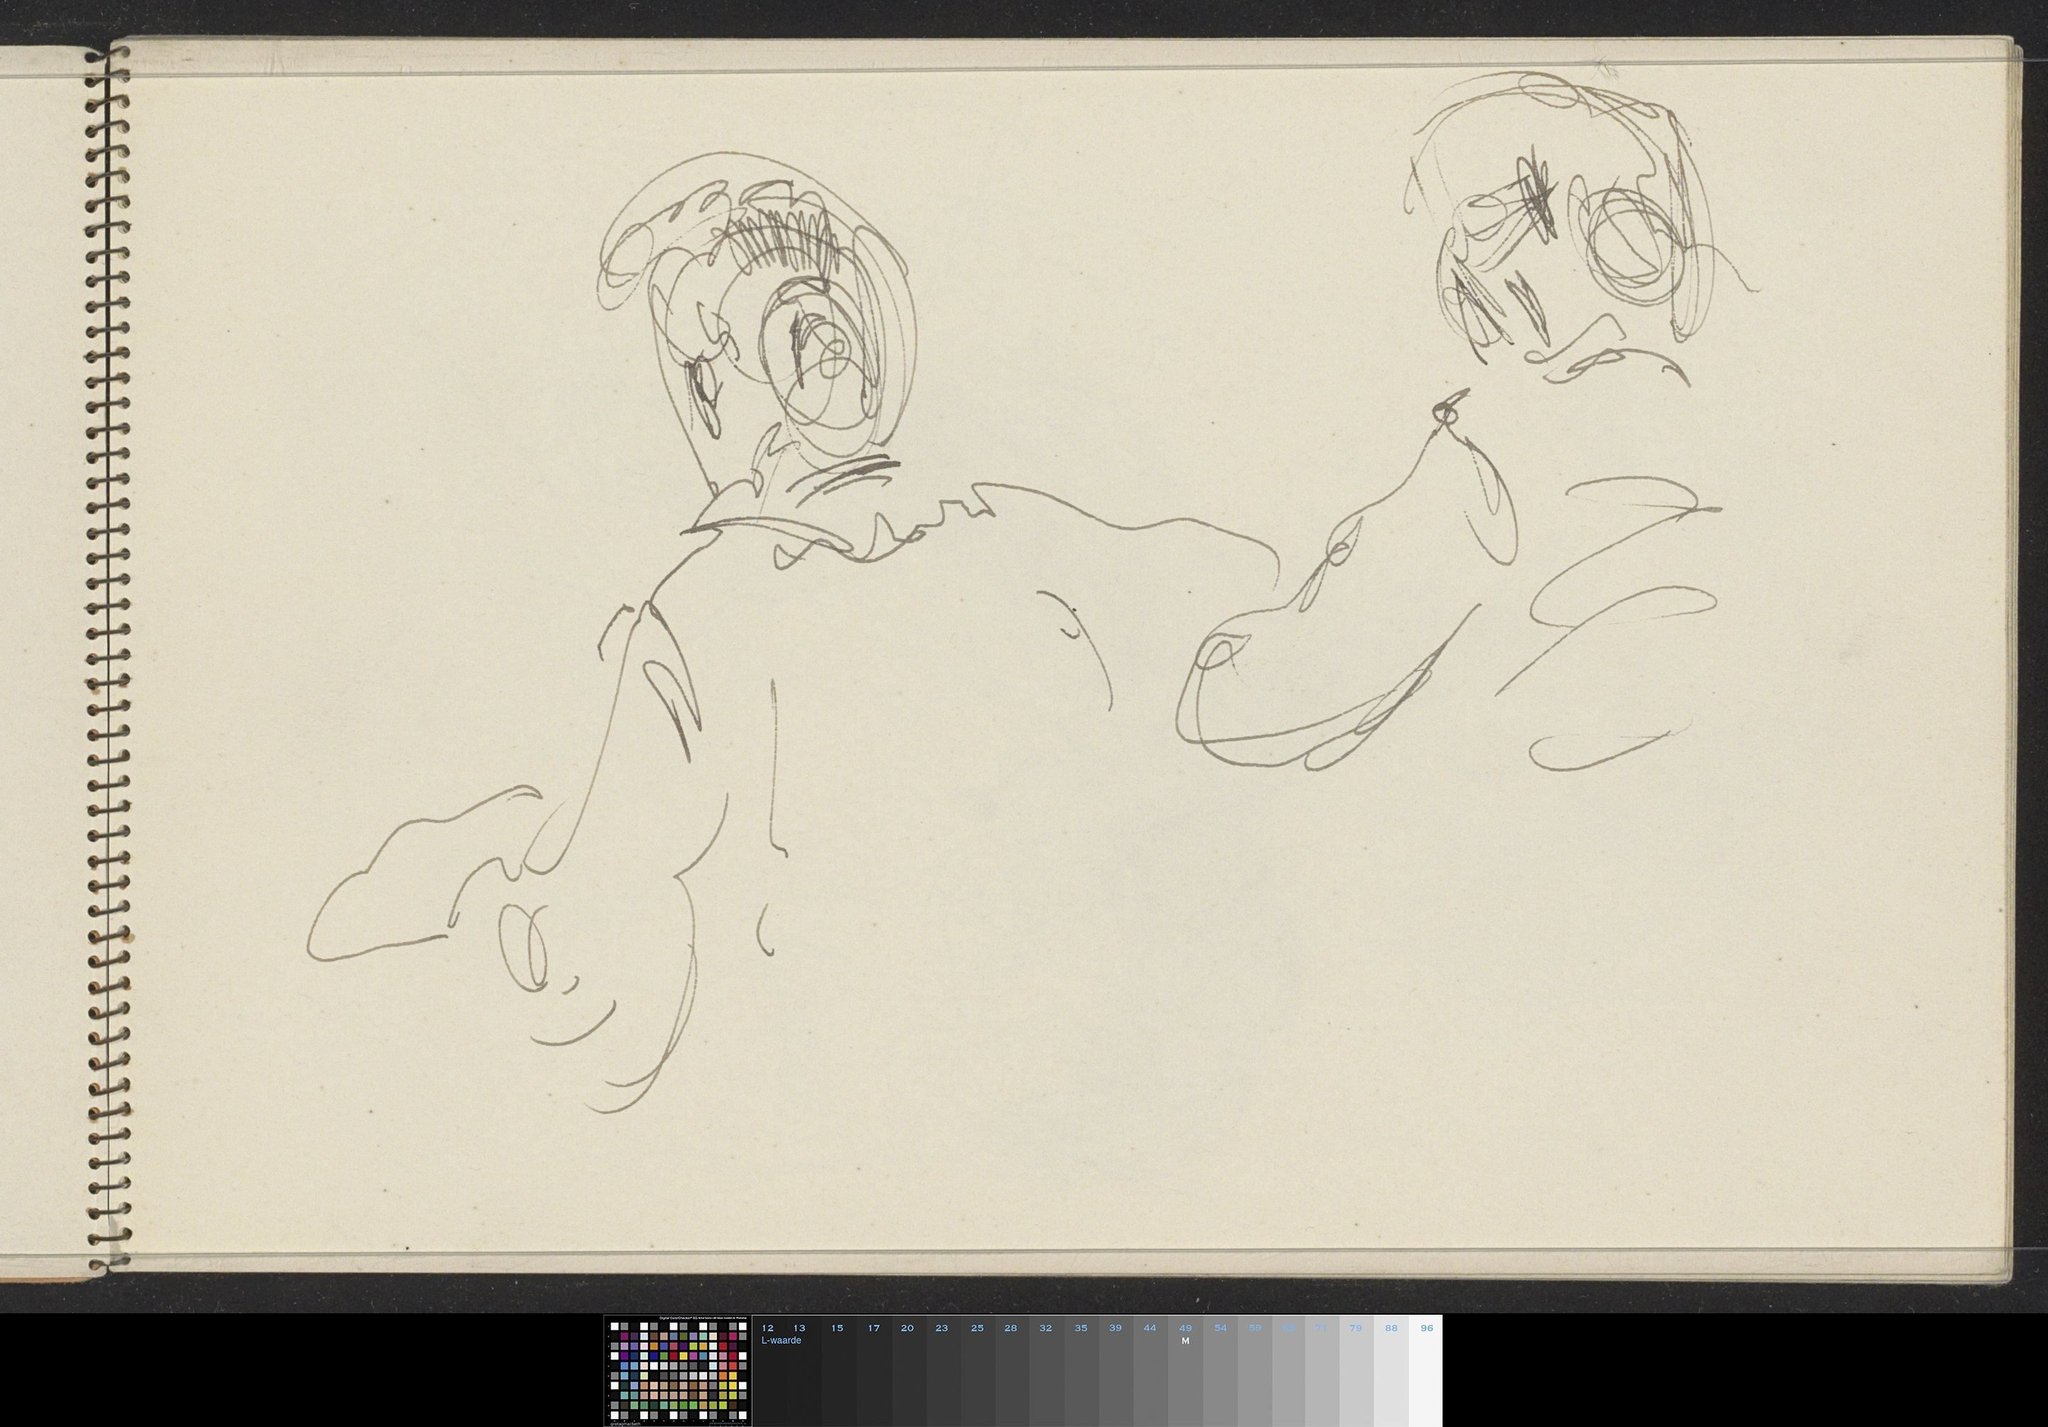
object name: sketchbook leaf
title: Rug van Joanna Lion Cachet-Cordes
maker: carel adolph lion cachet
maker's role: draughtsman, print maker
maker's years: 1864-1945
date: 1935-1940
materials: ink, paper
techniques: pen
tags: adult woman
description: Blad 2 recto uit een schetsboek met 25 bladen.